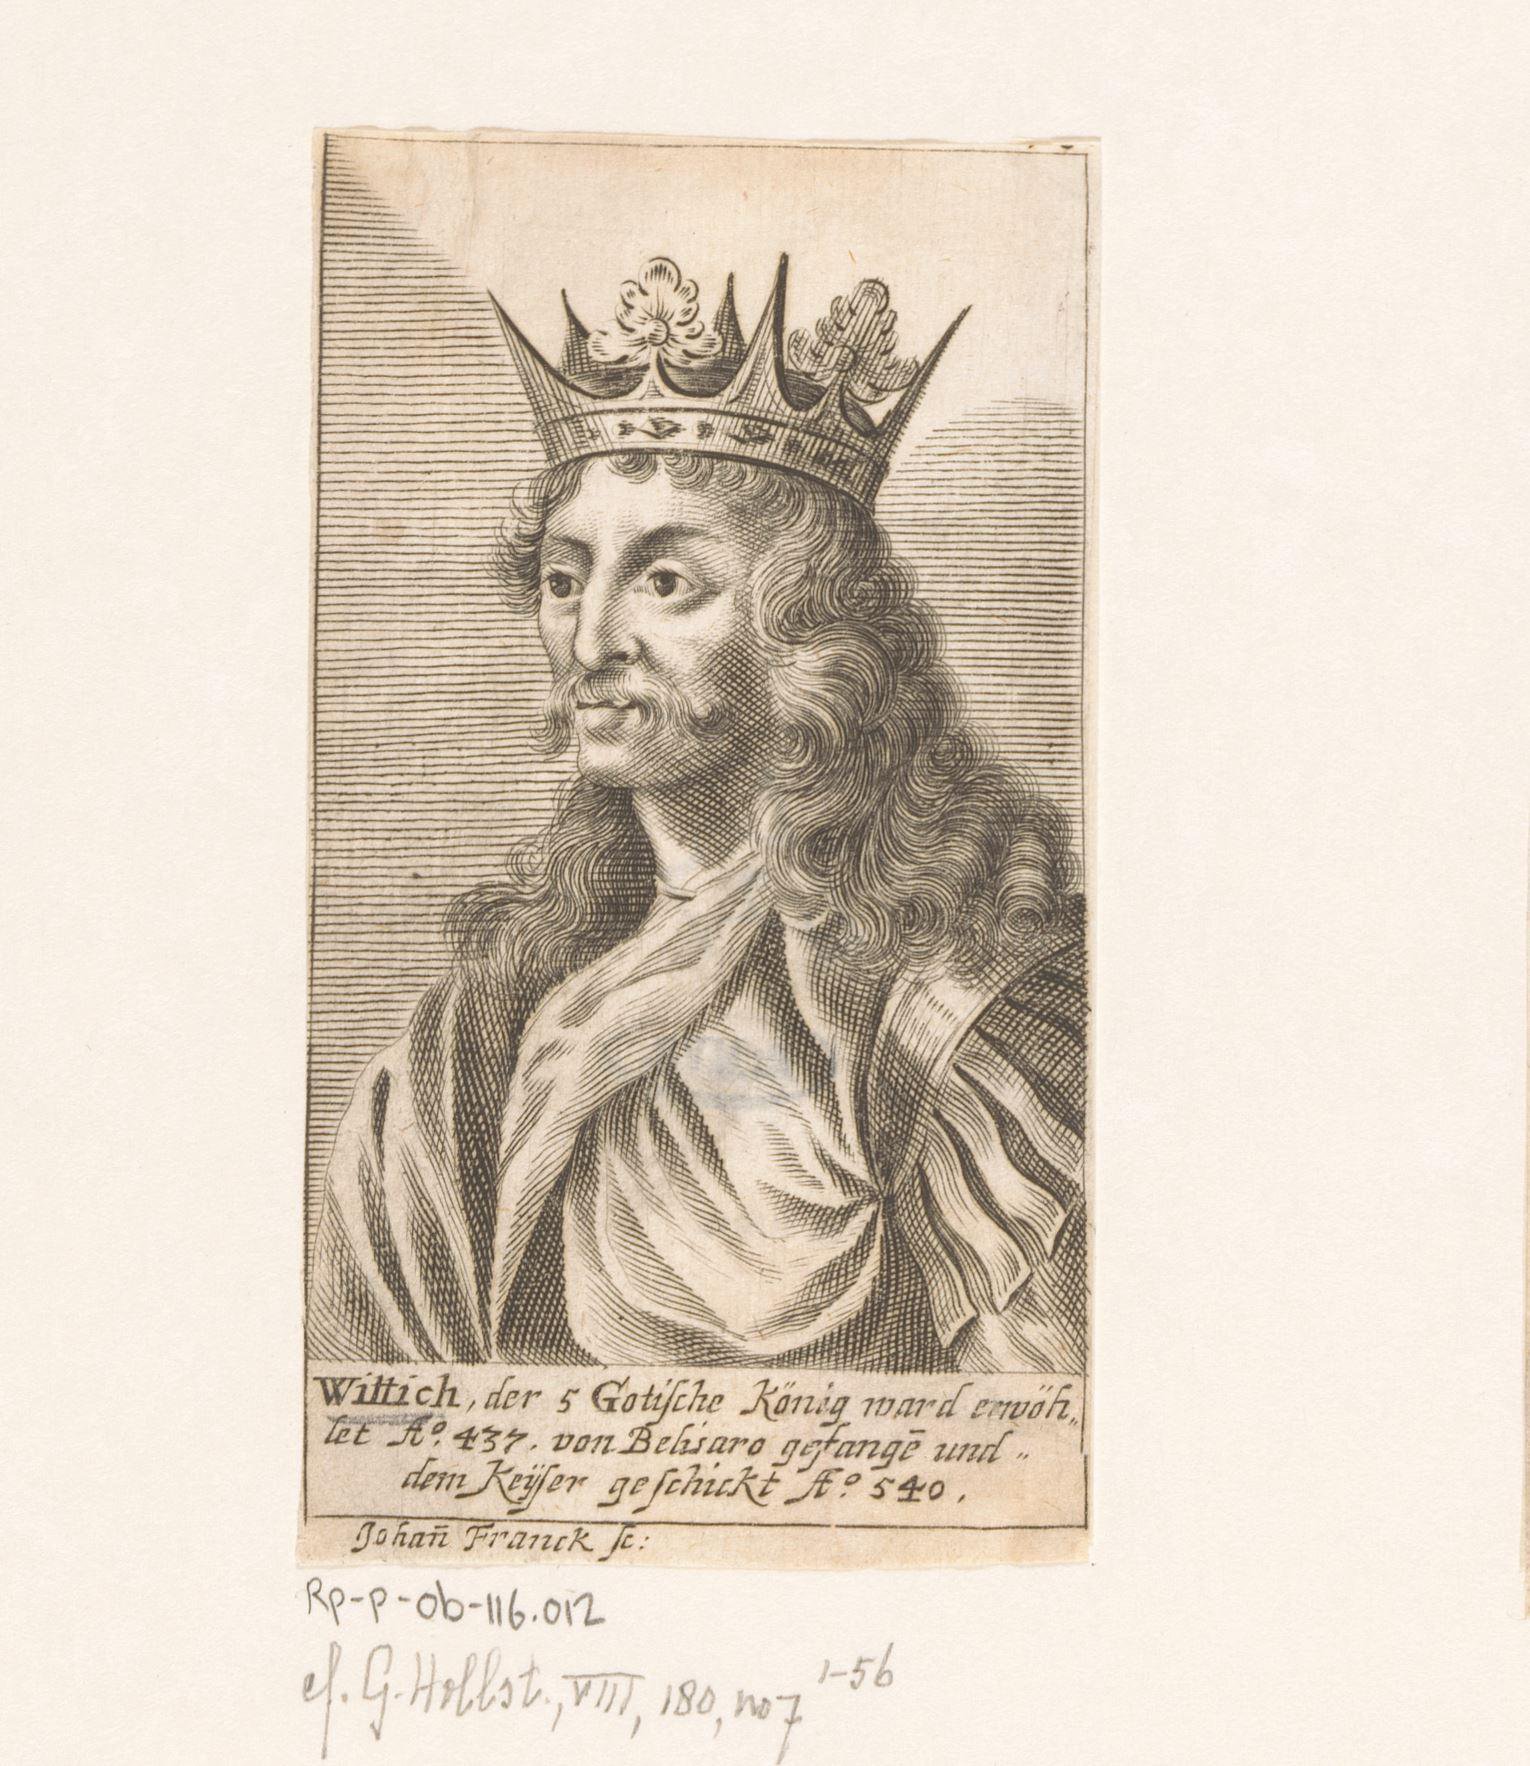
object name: print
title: Portret van koning Witiges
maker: johann franck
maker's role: print maker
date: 1650-1699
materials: paper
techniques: engraving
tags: crown (symbol of sovereignty), historical persons, ruler, sovereign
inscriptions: collector's mark: Lugt 2228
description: Onderdeel van een serie, bestaande uit 56 portretten van koningen van Lombardije.